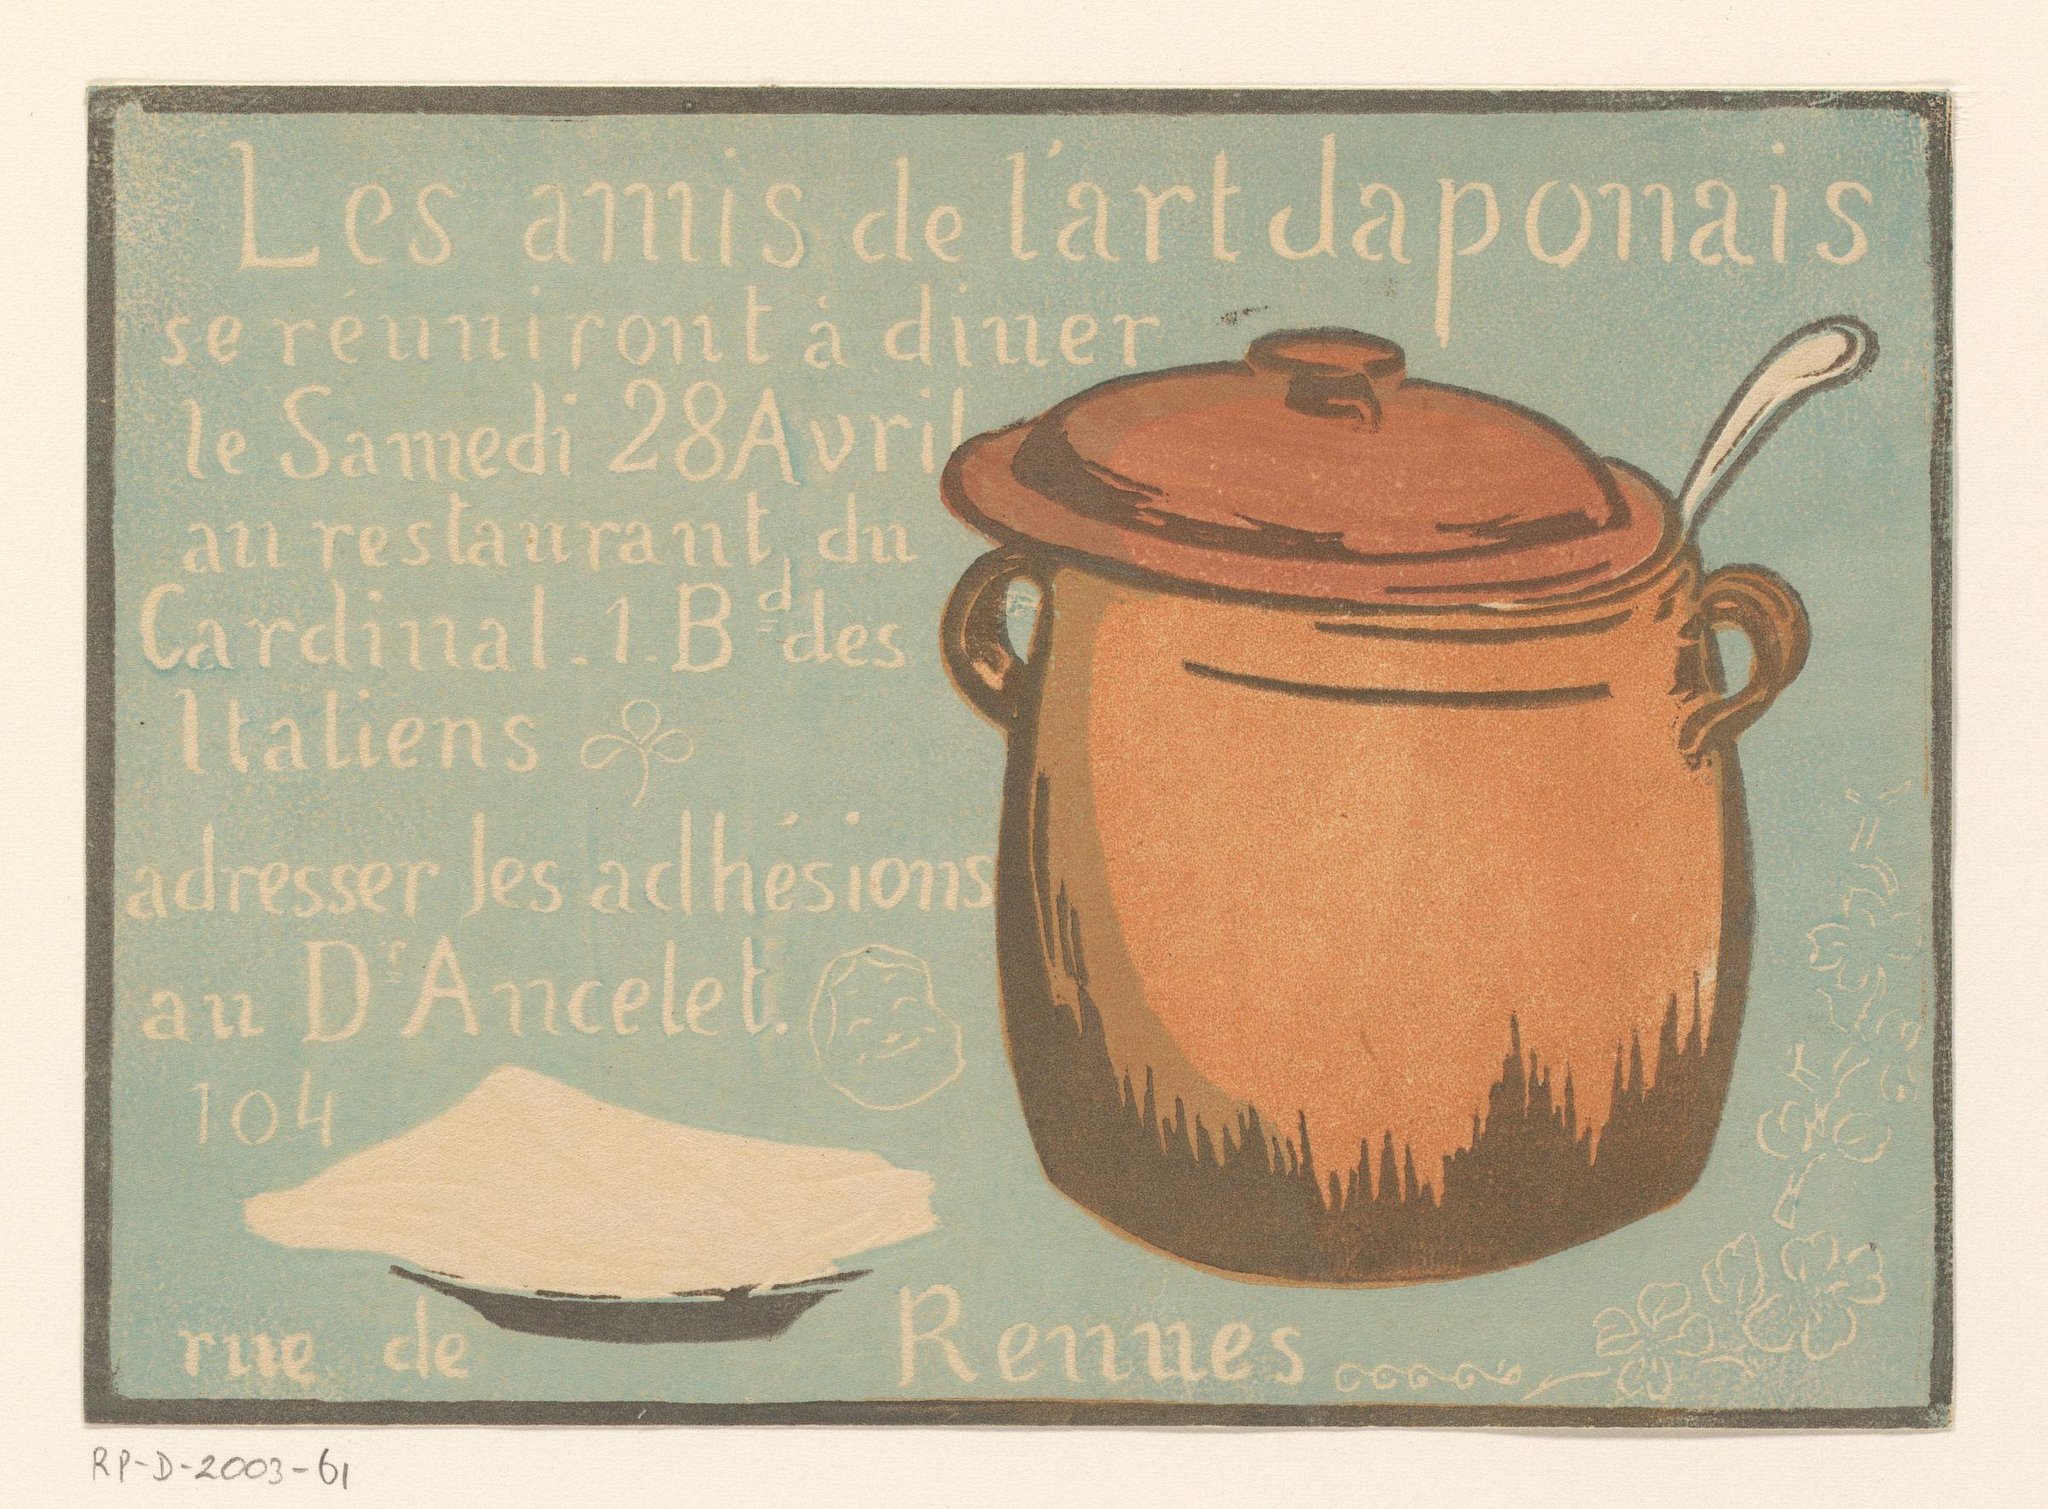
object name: invitation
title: Uitnodiging voor een diner van Les Amis de l'Art Japonais, 28 april 1906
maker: prosper-alphonse isaac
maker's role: draughtsman, print maker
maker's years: 1858-1924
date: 1904-1906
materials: paper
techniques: woodcut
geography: france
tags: kitchen-utensils, containers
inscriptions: collector's mark: Lugt 2228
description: Soepketel en handdoek. Uitnodiging voor een diner van Les Amis de l'Art Japonais, 28 april 1906.